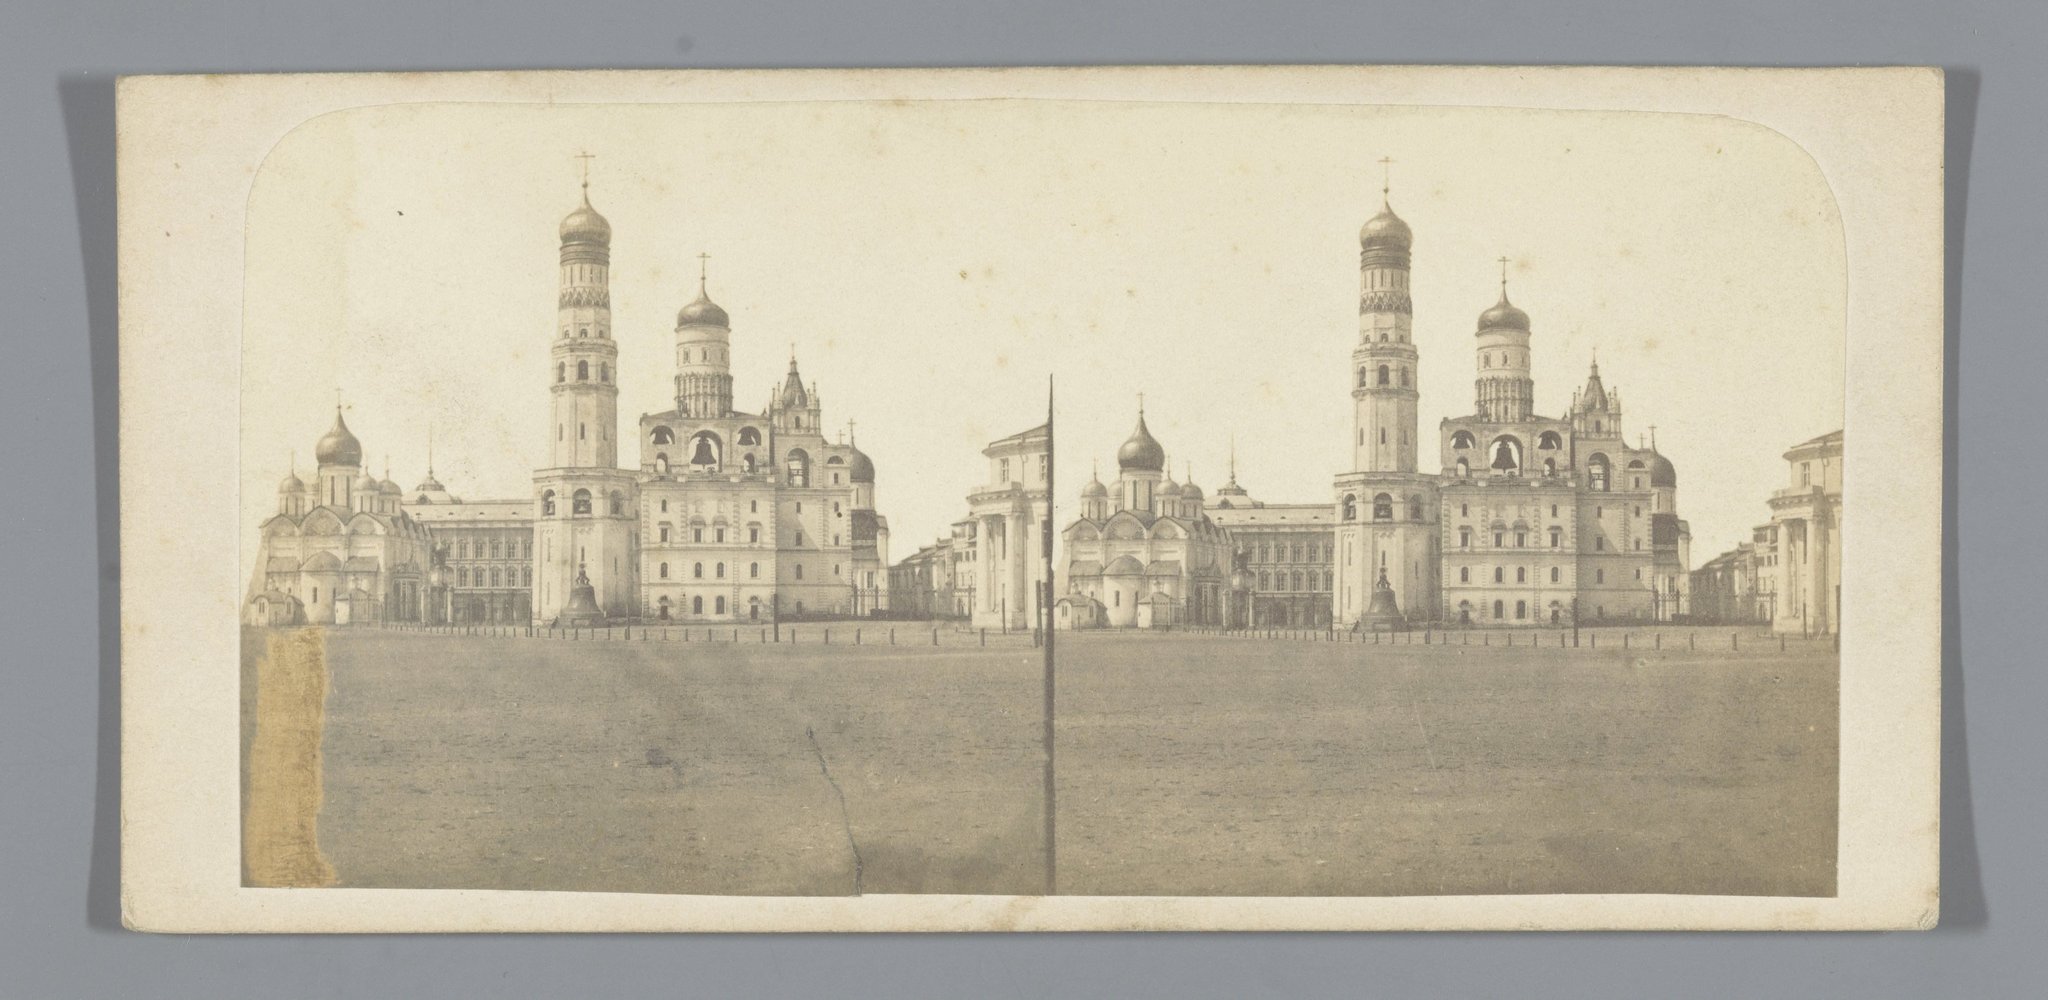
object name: stereograph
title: Gezicht op de klokkentoren van Ivan de Grote in het Kremlin te Moskou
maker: Anonymous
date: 1850-1880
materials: cardboard, photographic support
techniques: albumen print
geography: moscow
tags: tower, clock tower ~ monumental adornment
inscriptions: number: ‘6’, inscription: ‘Moscou, Tour Iwan Wilichi au Kremlin’